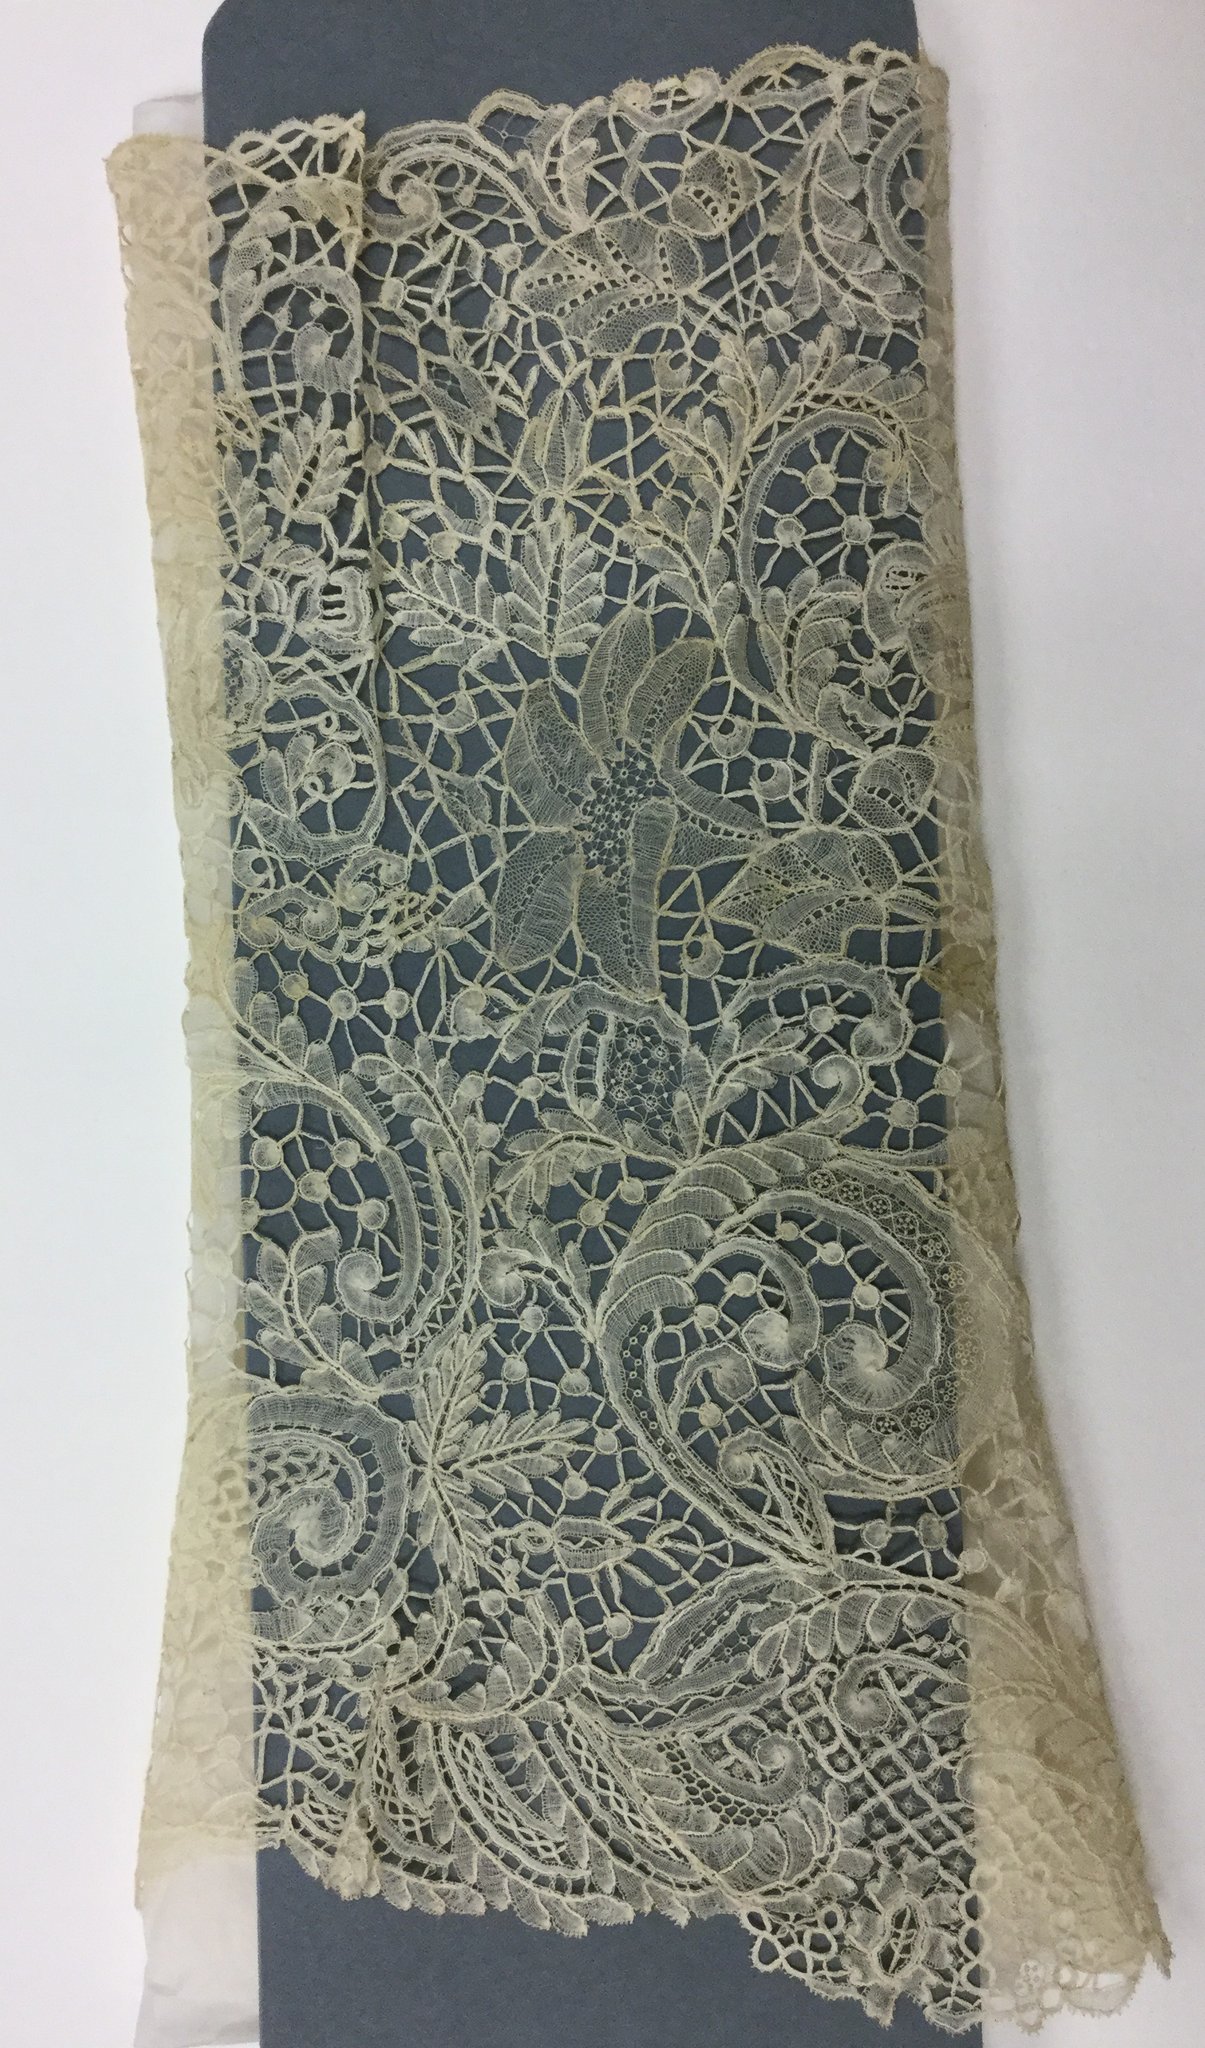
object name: sleeve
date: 1801-1900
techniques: lace